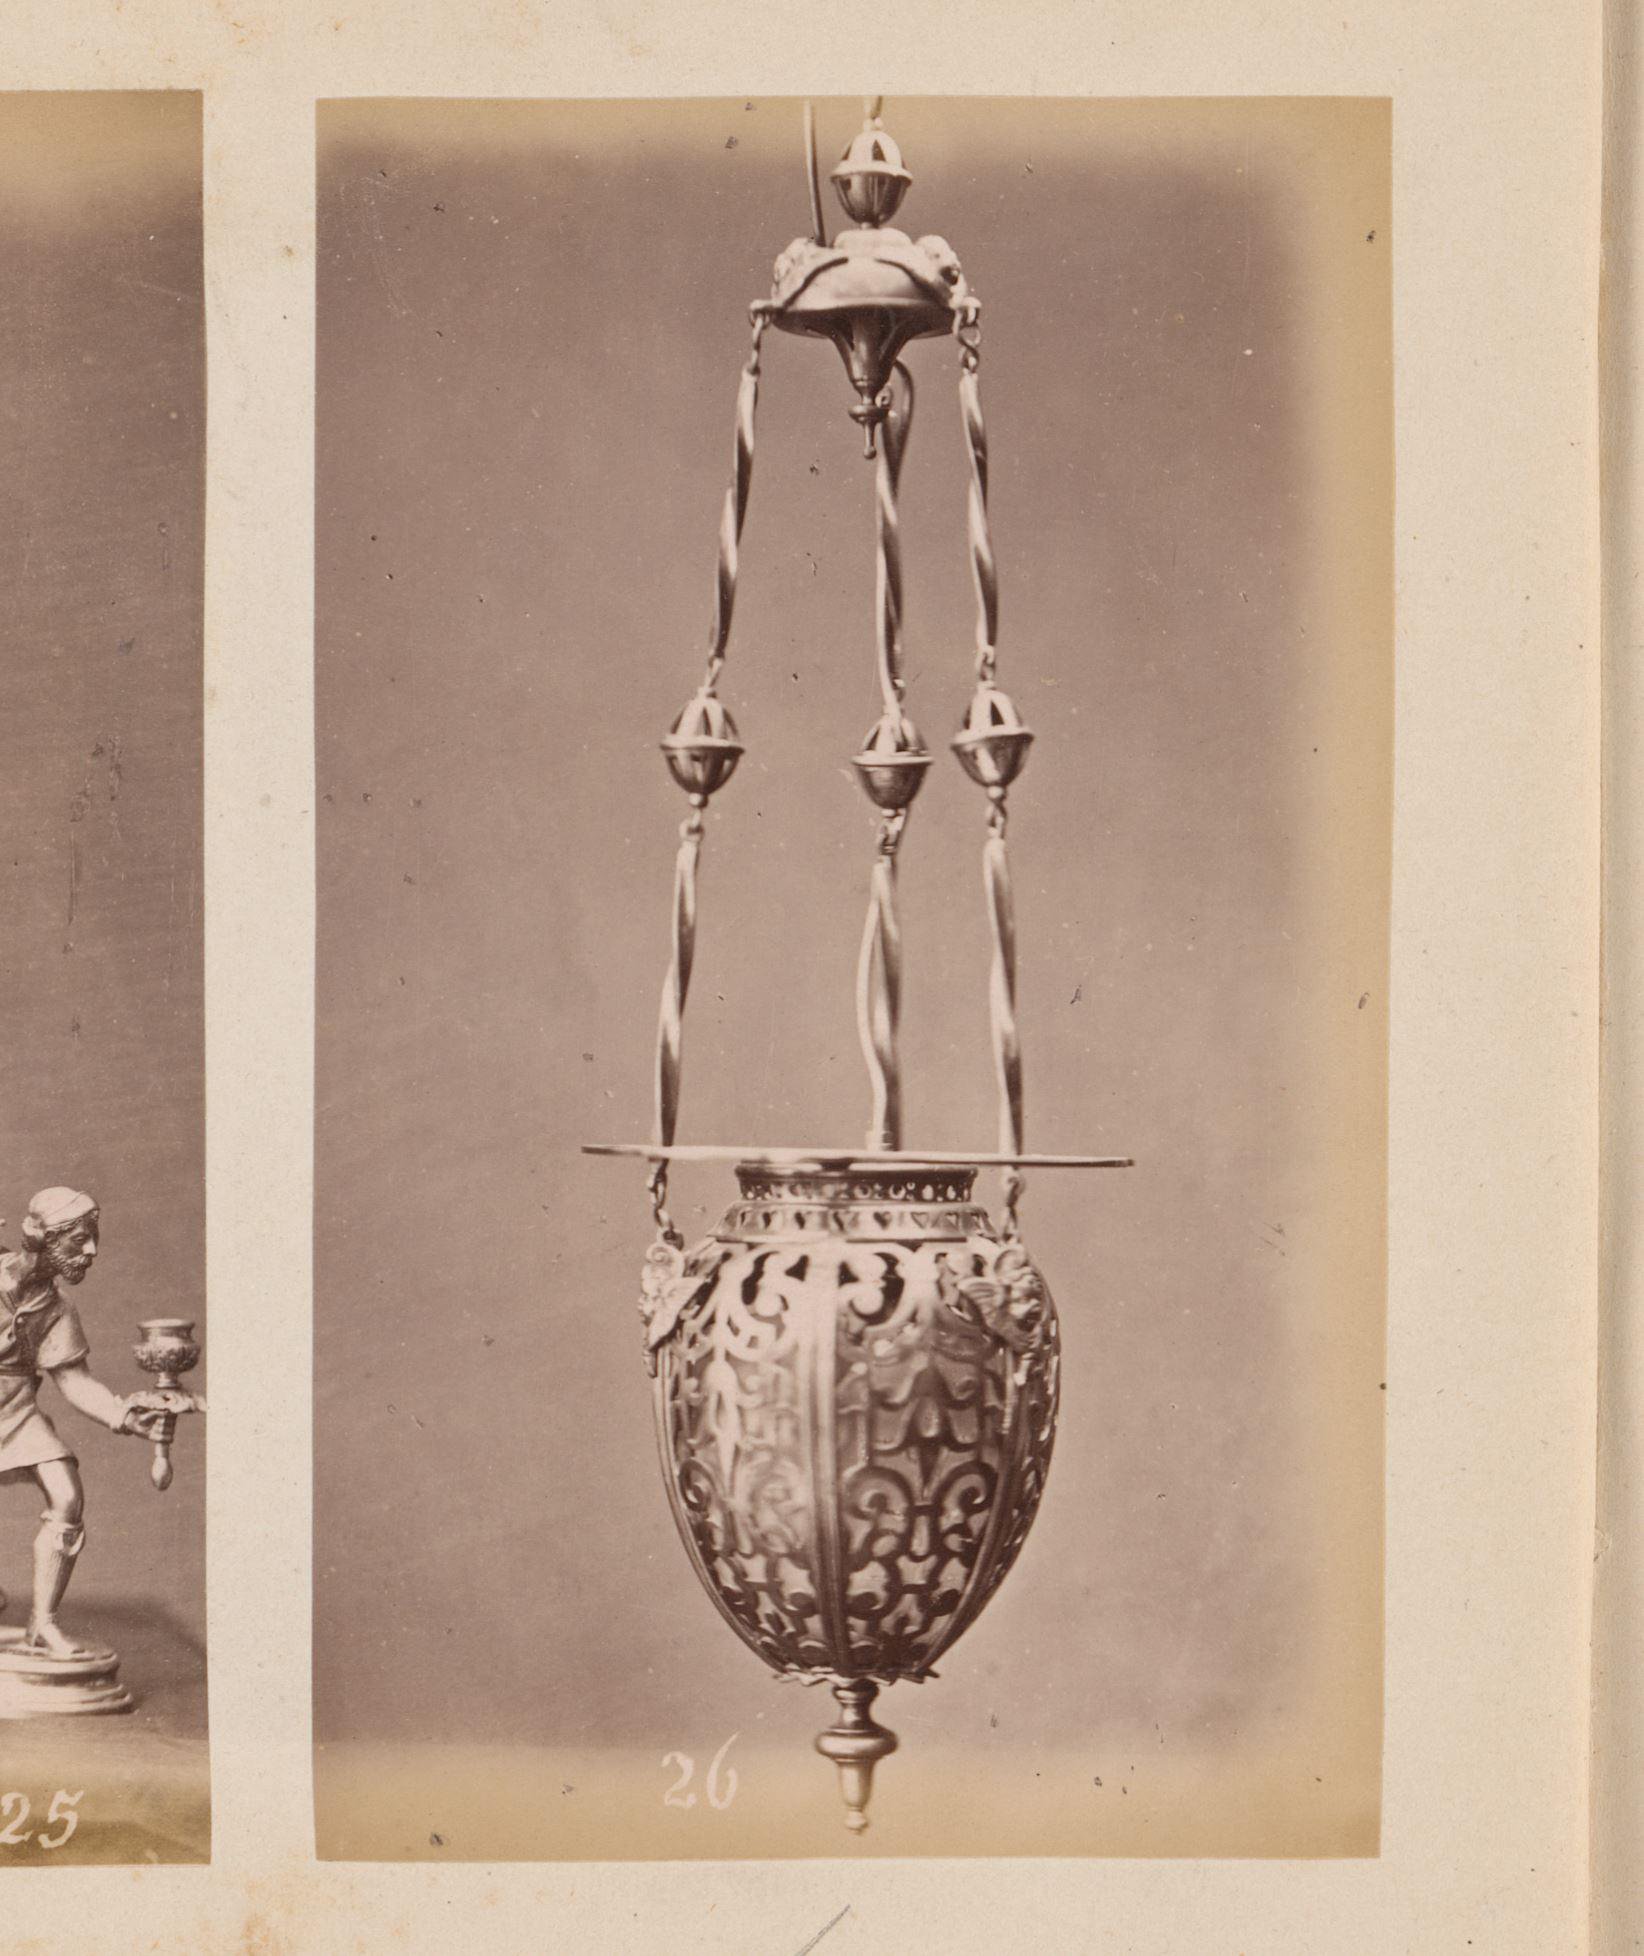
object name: photograph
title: Metalen hanglamp in San Marco model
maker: Anonymous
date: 1860-1885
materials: photographic support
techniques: albumen print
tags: lighting; lamps